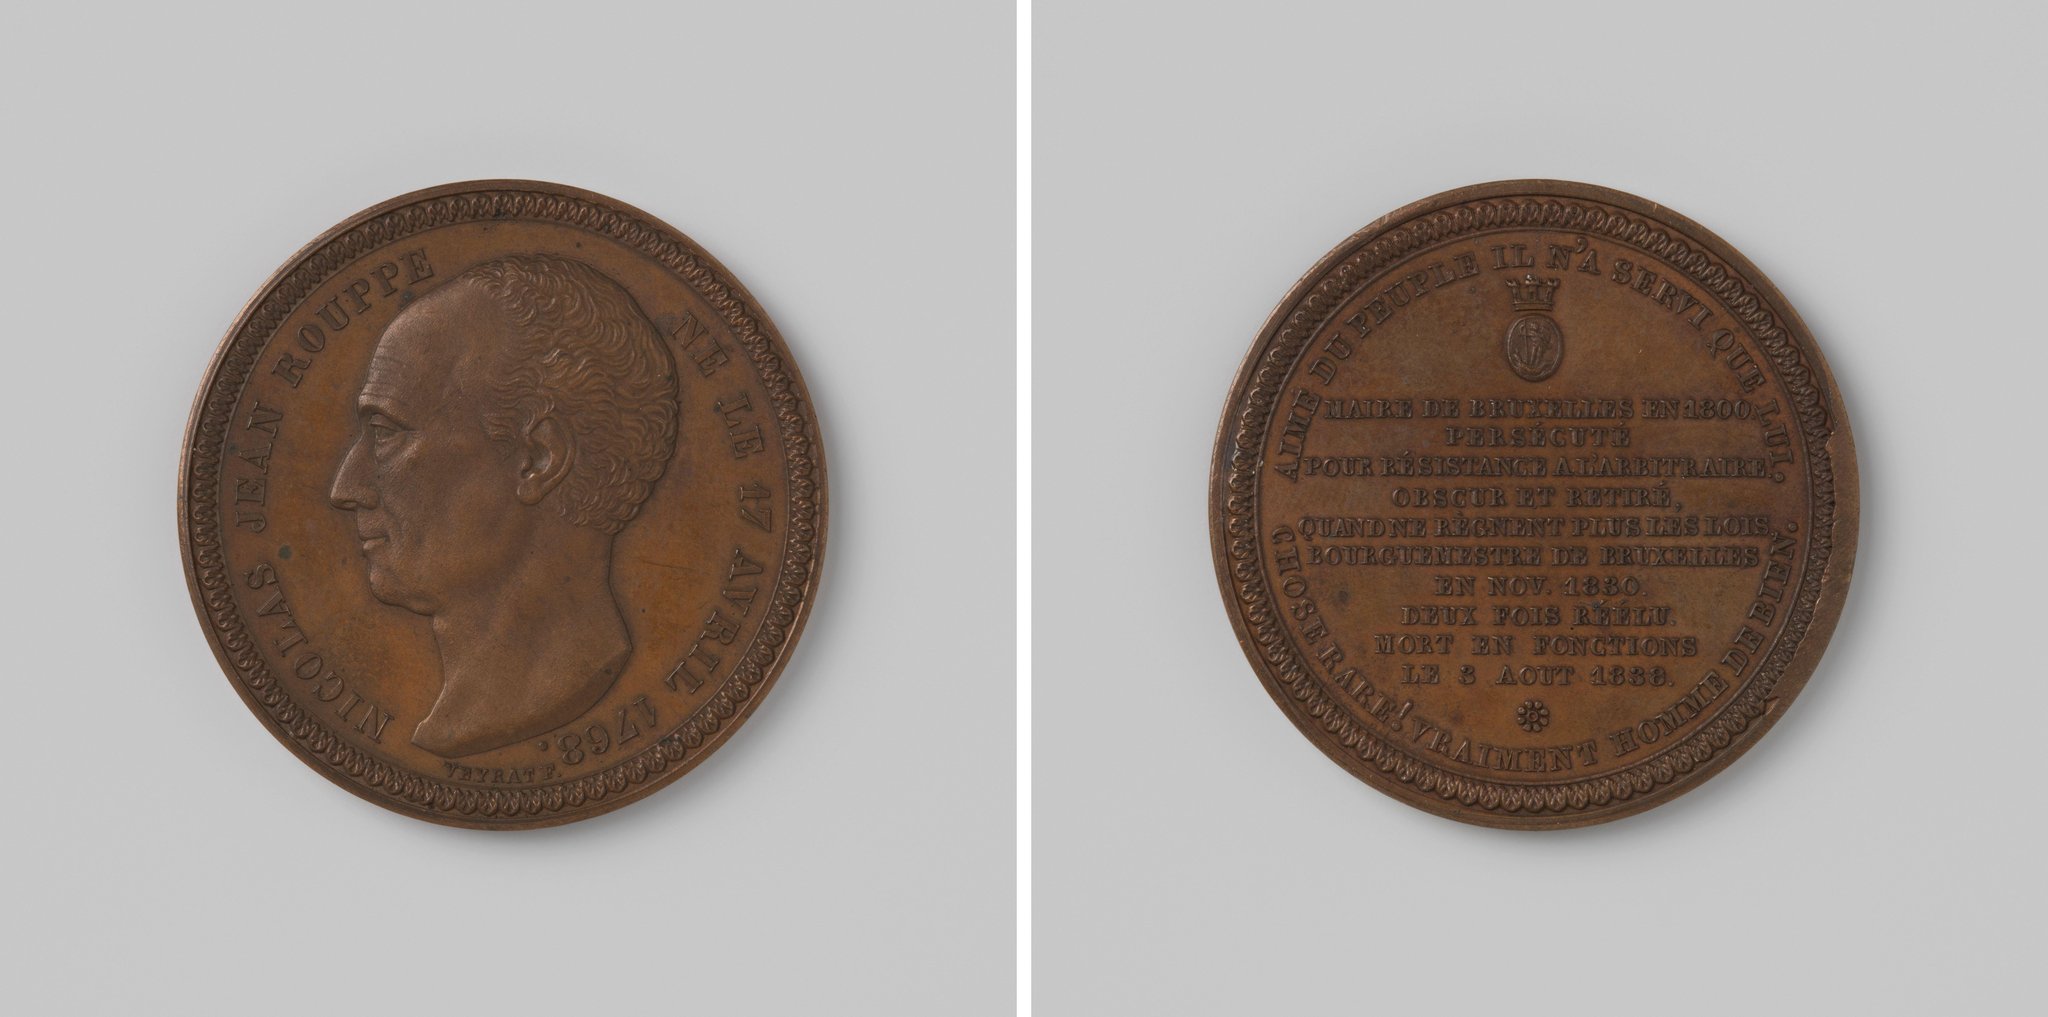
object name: history medal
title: Overlijden van Niklaas Jan Rouppe, burgemeester van Brussel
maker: adrien hippolyte veyrat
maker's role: medailleur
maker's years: 1803-1883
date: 1838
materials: bronze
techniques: striking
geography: brussels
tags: brussels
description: Bronzen penning. Voorzijde: borststuk man binnen omschrift. Keerzijde: opschrift onder gekroond medaillonvan St. Michael binnen omschrift en sierrand